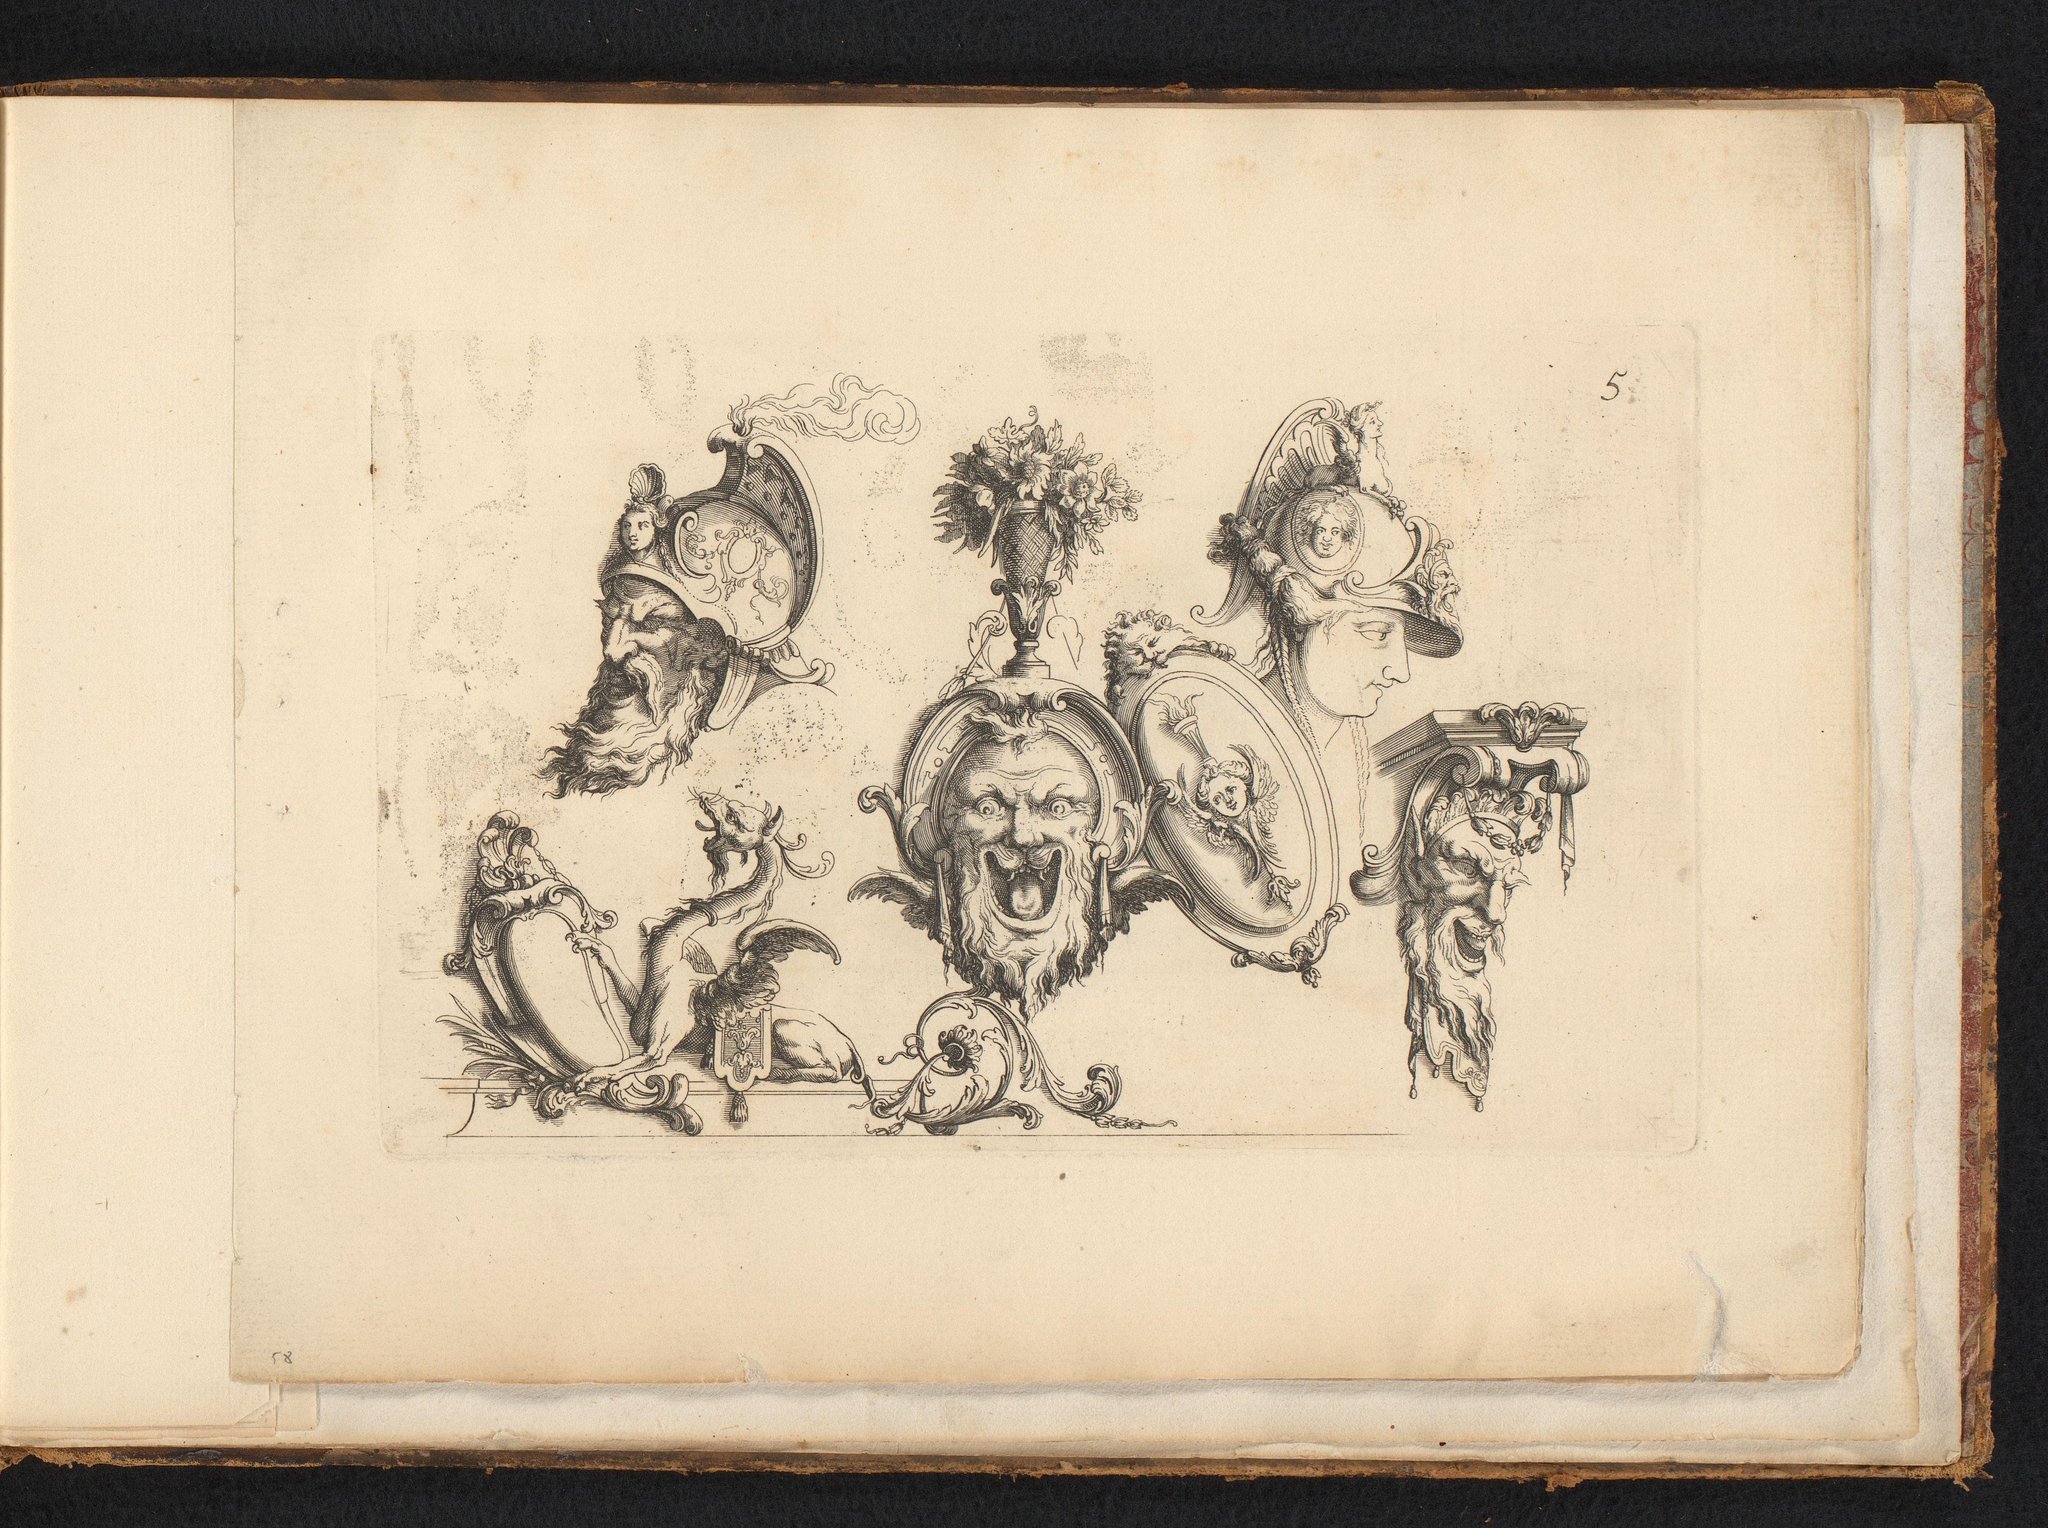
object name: print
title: Ontwerpen voor maskers en andere ornamenten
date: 1745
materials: paper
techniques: etching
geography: london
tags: fabulous animals (sometimes wrongly called 'grotesques'); 'mostri' (ripa), satyr(s) (in general), mask, mascaron ~ ornament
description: Rechtsboven genummerd: 5. Prent maakt deel uit van een album.